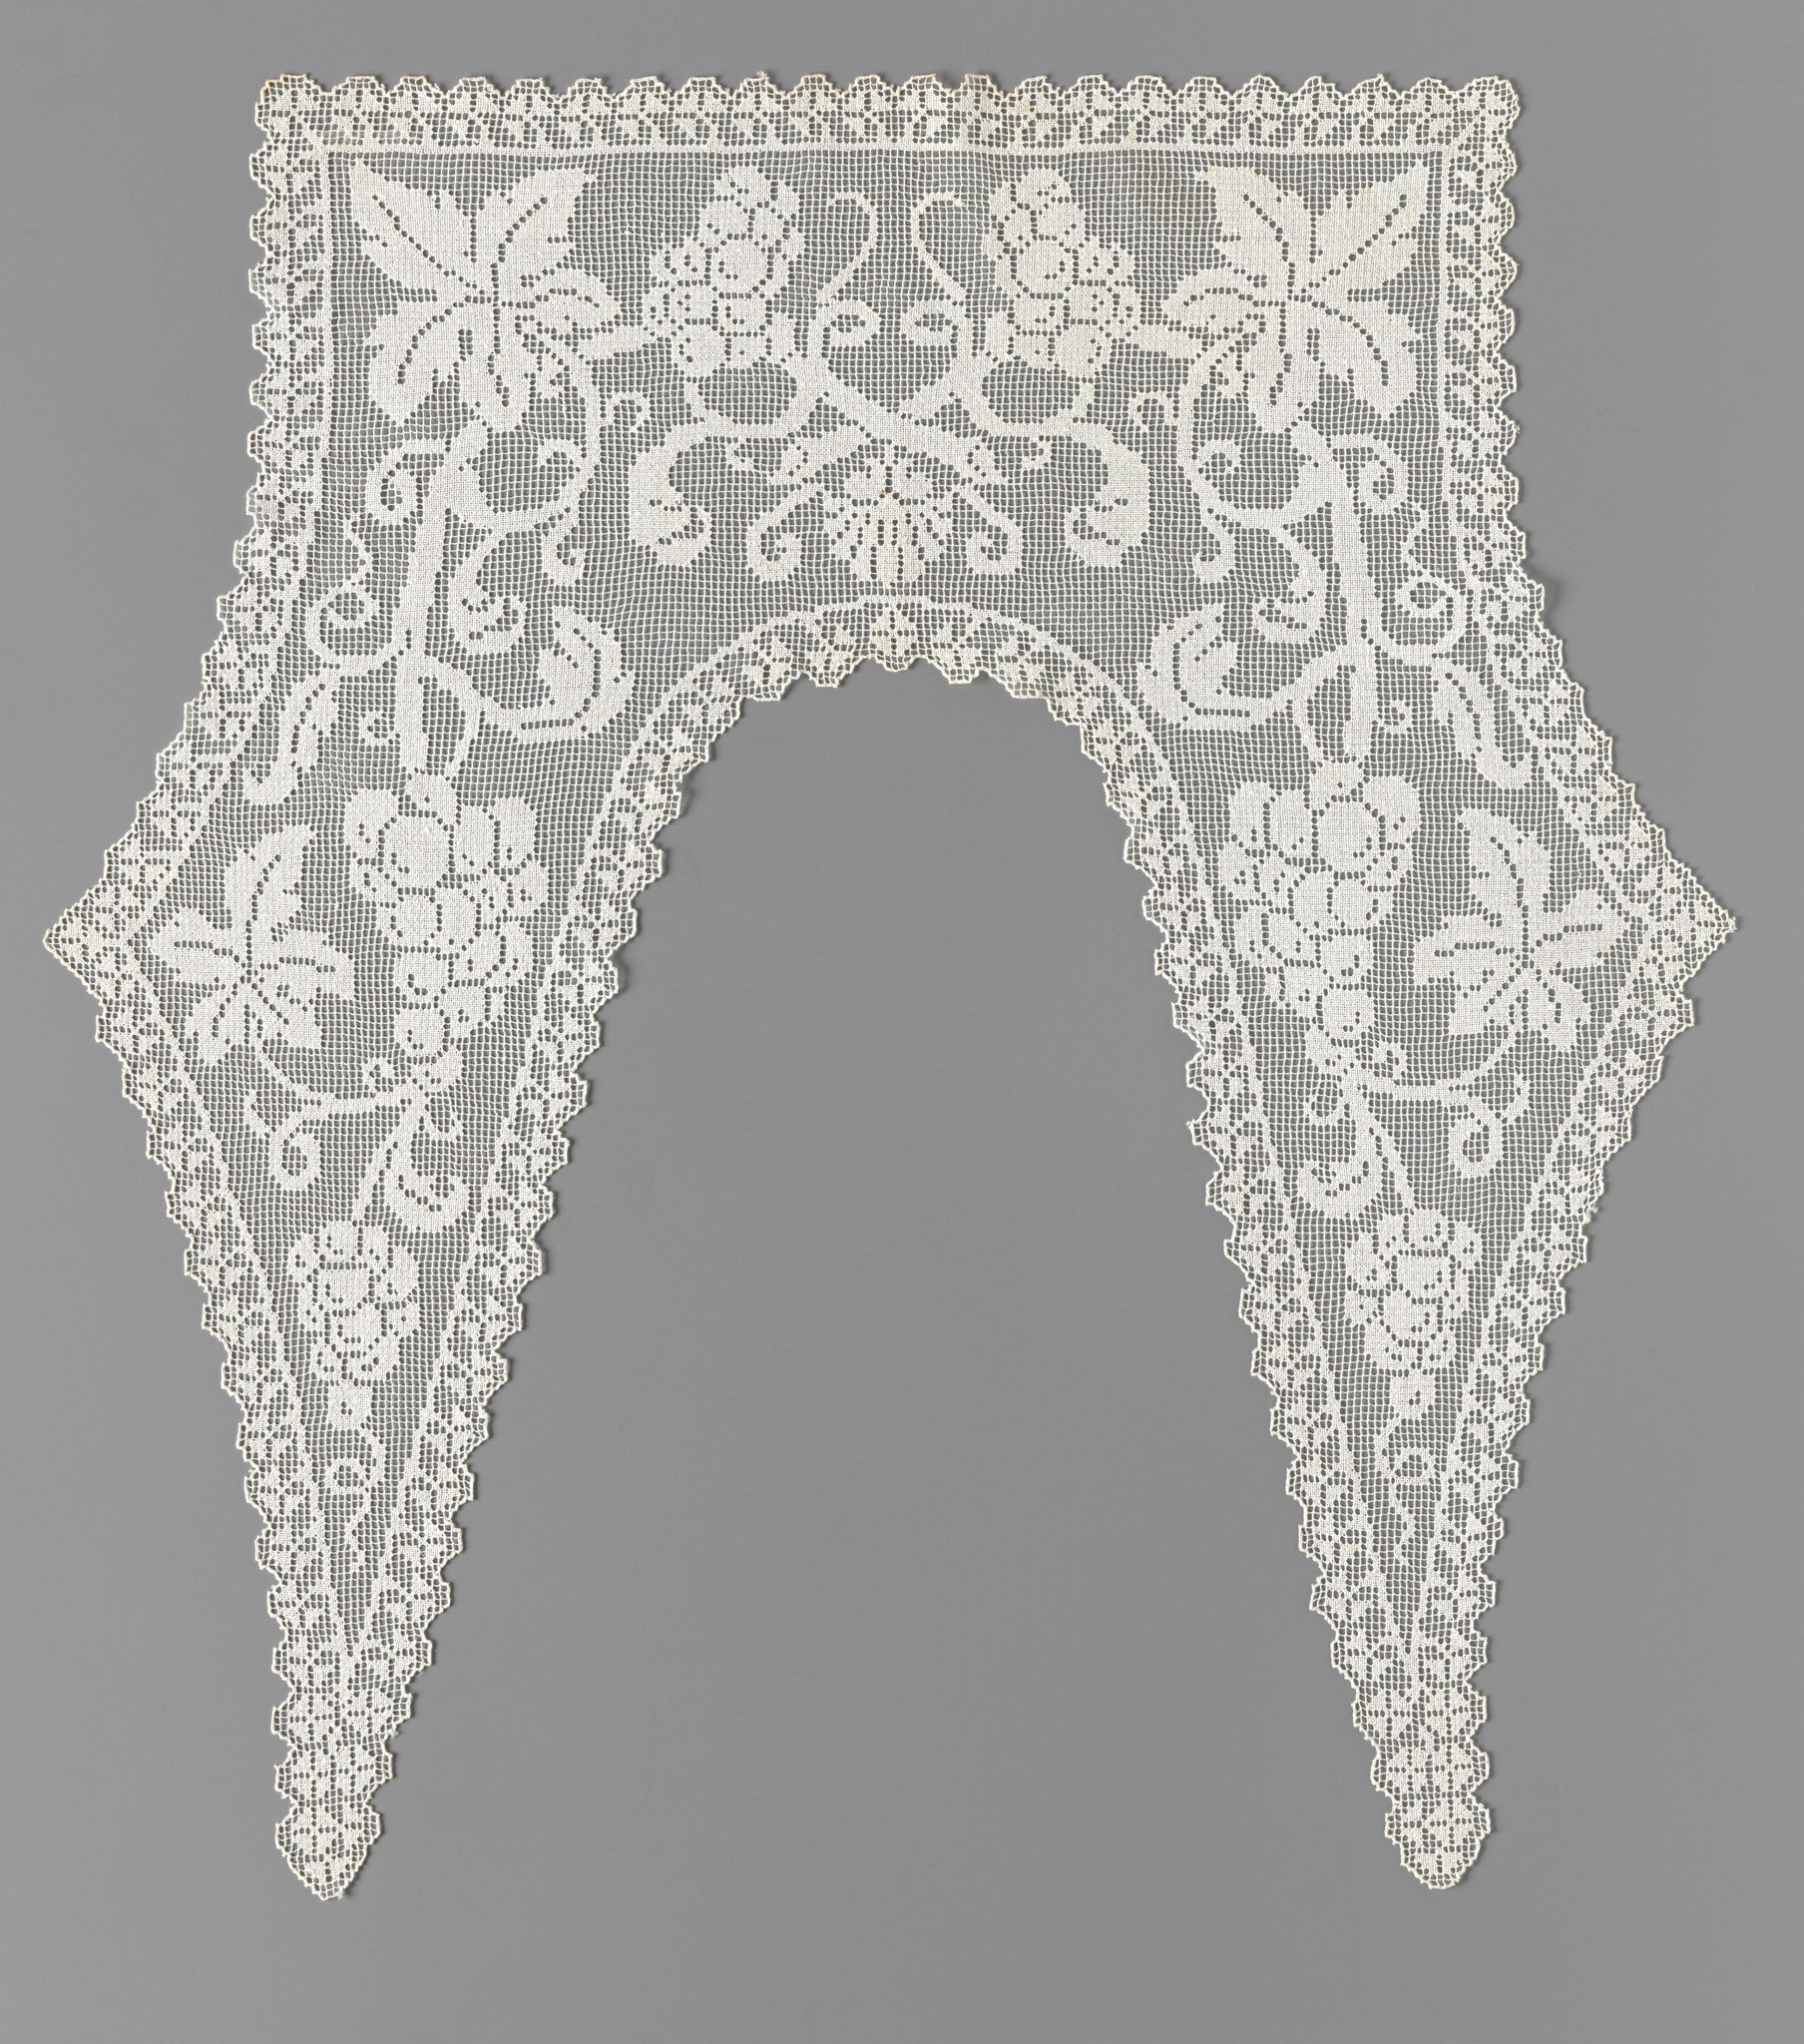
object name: womenswear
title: Kraag van filetkant met druiventrossen aan wijnranken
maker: Anonymous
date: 1915-1920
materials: cotton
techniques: stopwork, filet lace, filet knotwork, lace embroidery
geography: netherlands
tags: bunch of grapes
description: Kraag van naturelkleurig kantborduurwerk: filetkant. Model met rechthoekig rugstuk en lange punten voor. Het patroon is symmetrisch en heeft op het rugstuk twee korte en gekruiste wijnranken met aan elk een druiventros. In elke punt hangen twee trossen druiven aan een wijnrank. De gehele rand bestaat uit kleine gestileerde anjers.